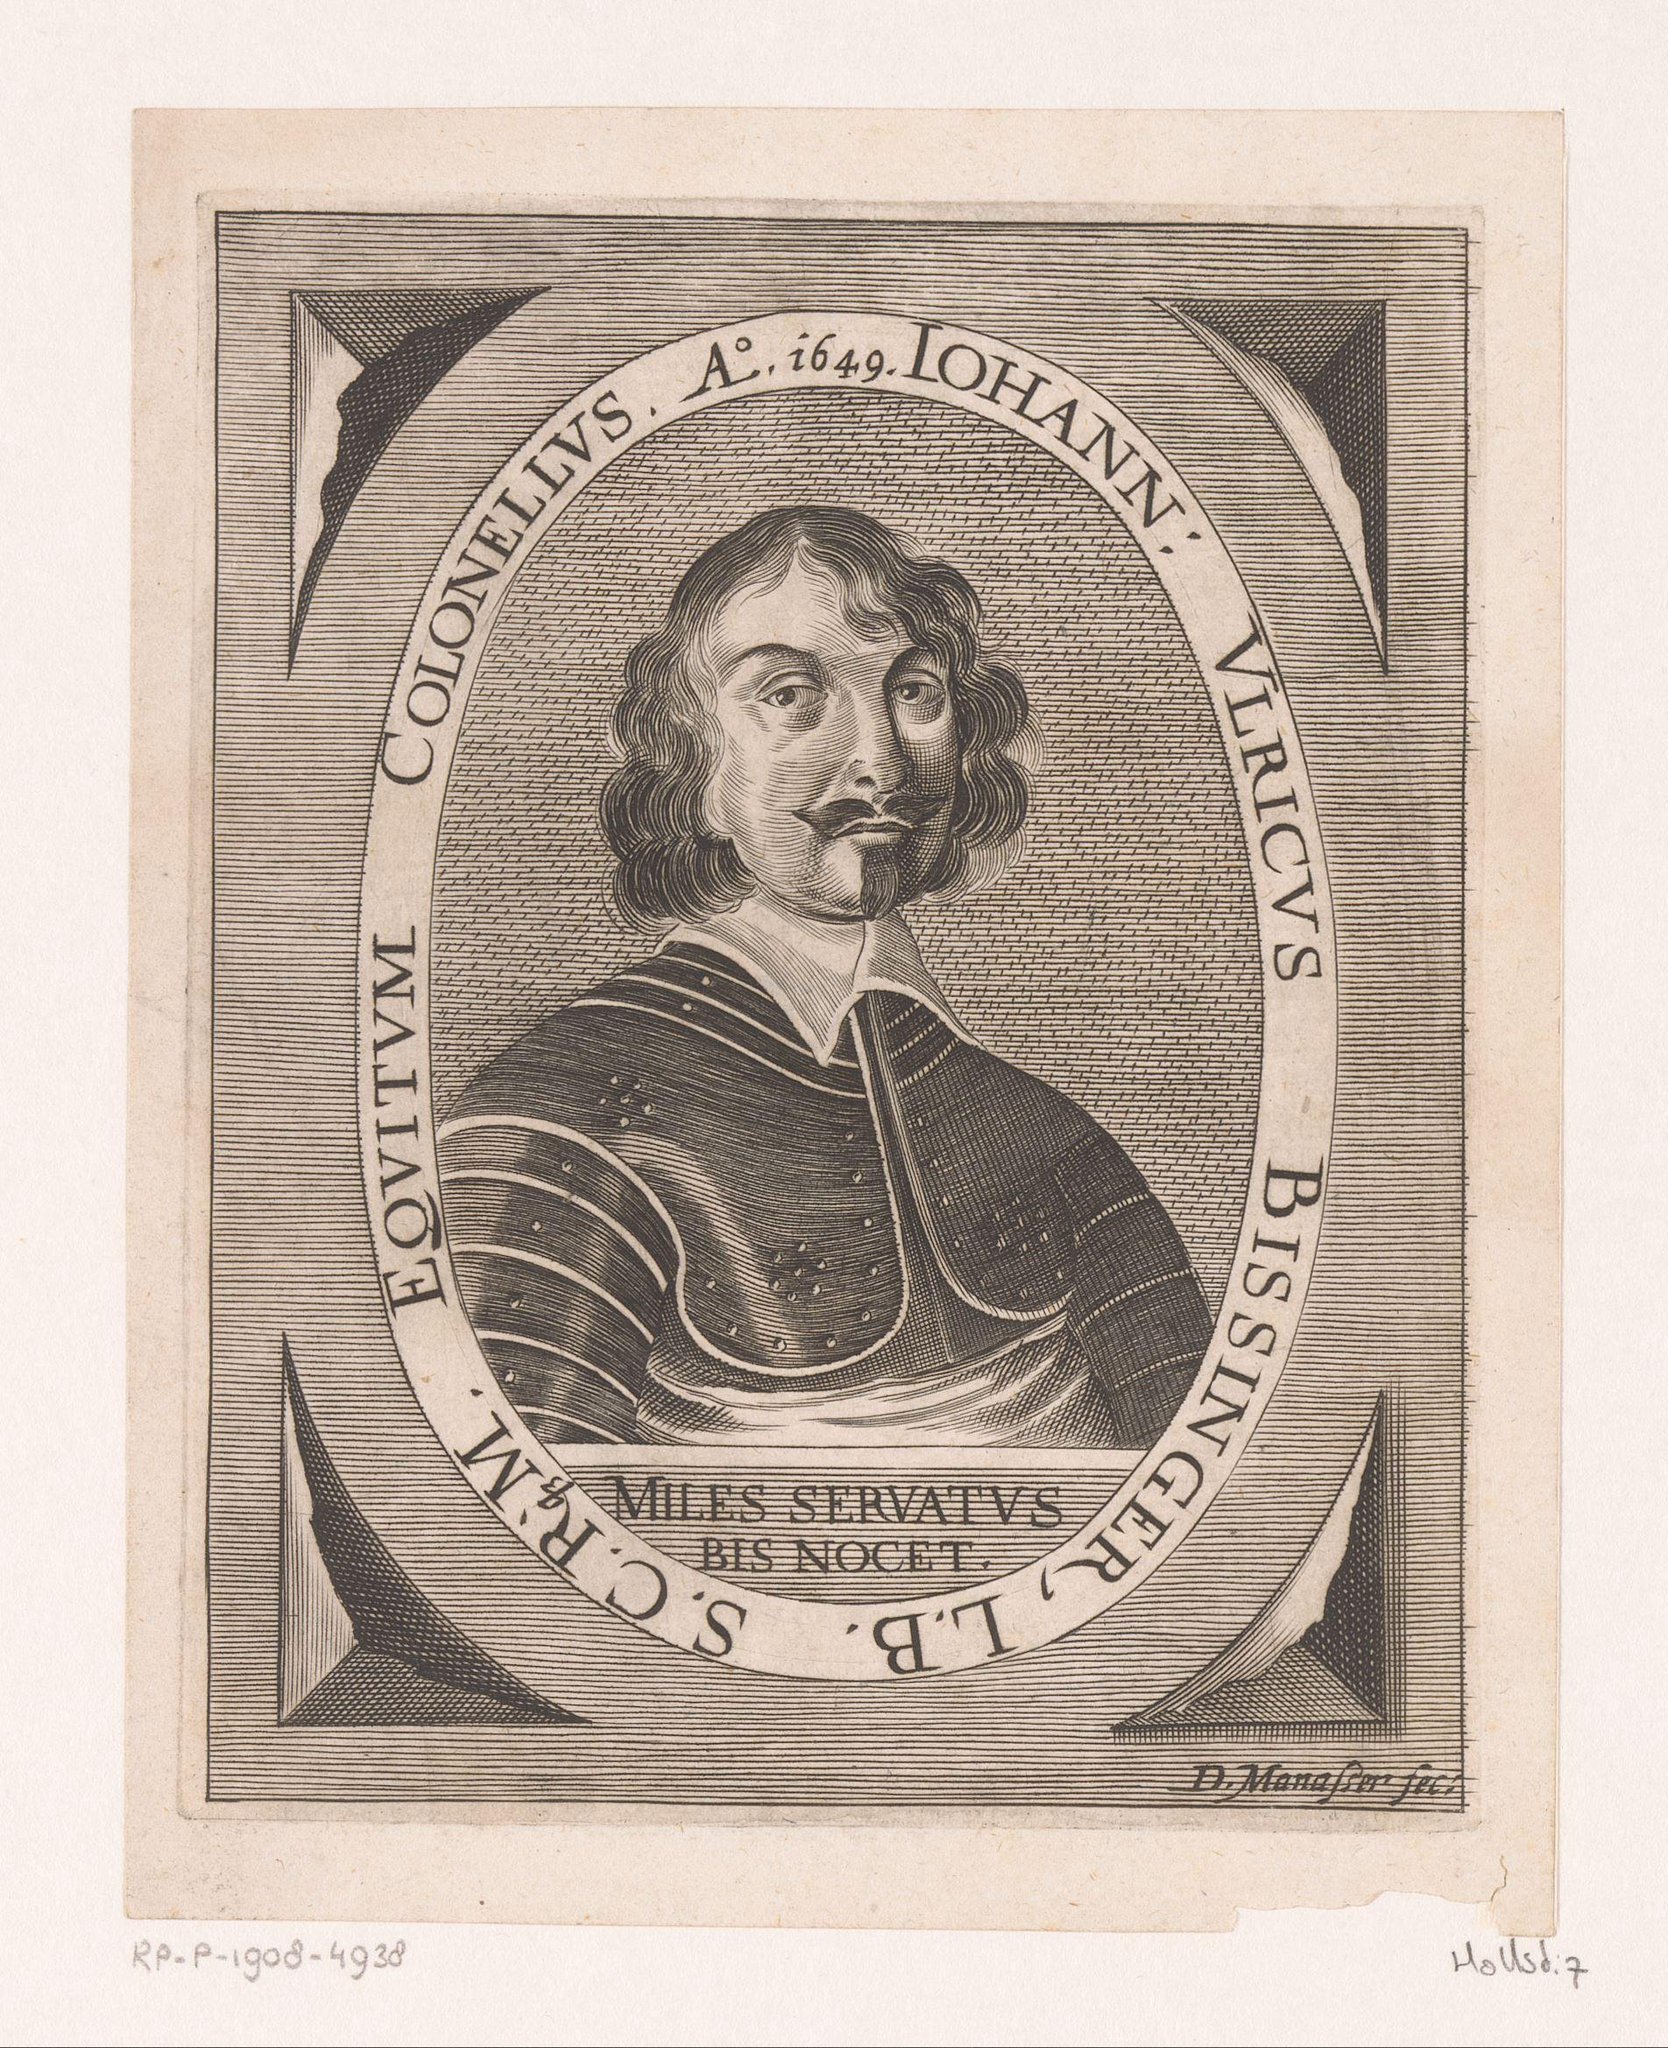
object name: print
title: Portretten van kolonels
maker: david mannasser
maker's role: print maker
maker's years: -1664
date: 1649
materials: paper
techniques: engraving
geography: graz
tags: historical persons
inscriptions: collector's mark: Lugt 2228